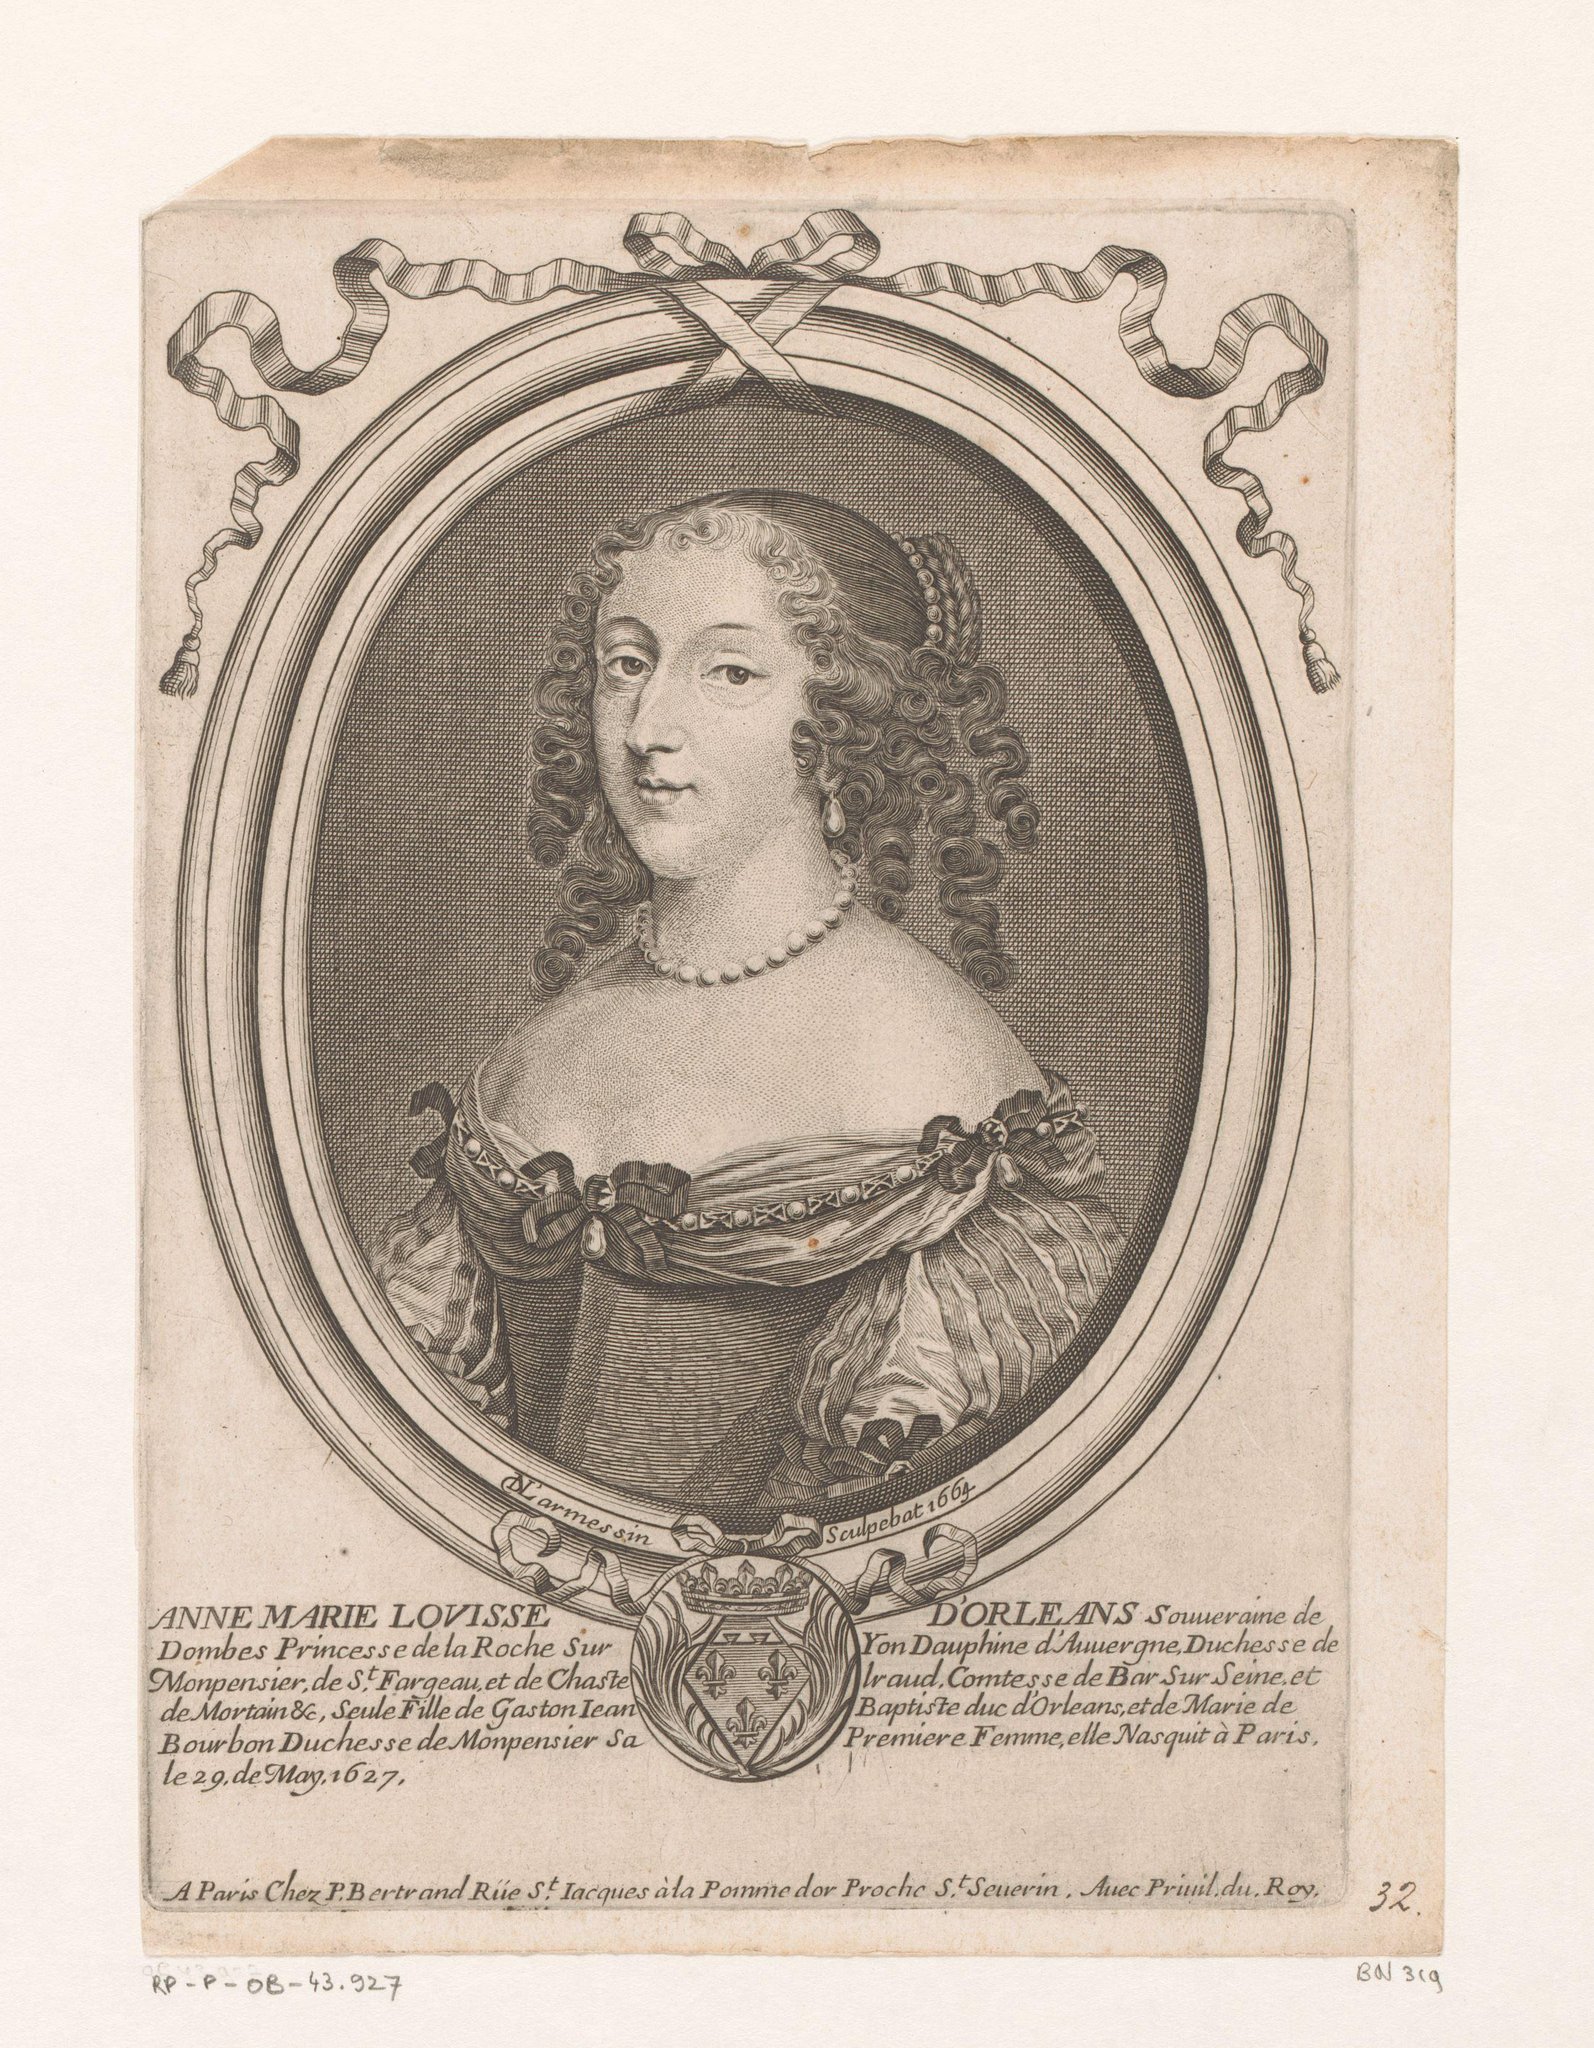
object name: print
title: Portretten van prominente figuren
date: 1664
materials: paper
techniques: engraving, etching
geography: france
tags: paris, anne marie louise d' orléans (hertogin van montpensier), historical persons, nobility and patriciate; chivalry, knighthood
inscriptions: collector's mark: Lugt 2228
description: Maakt deel uit van een grootschalige serie met portretten van prominente figuren. Binnen de serie bevindt zich een sectie getiteld 'Les Augustes Représentations De tous les Roys De France depuis Pharamond Iusqu'à Louys XIIII'. De serie werd respectievelijk uitgegeven door Pierre Bertrand, door zijn weduwe en door De Larmessin zelf.